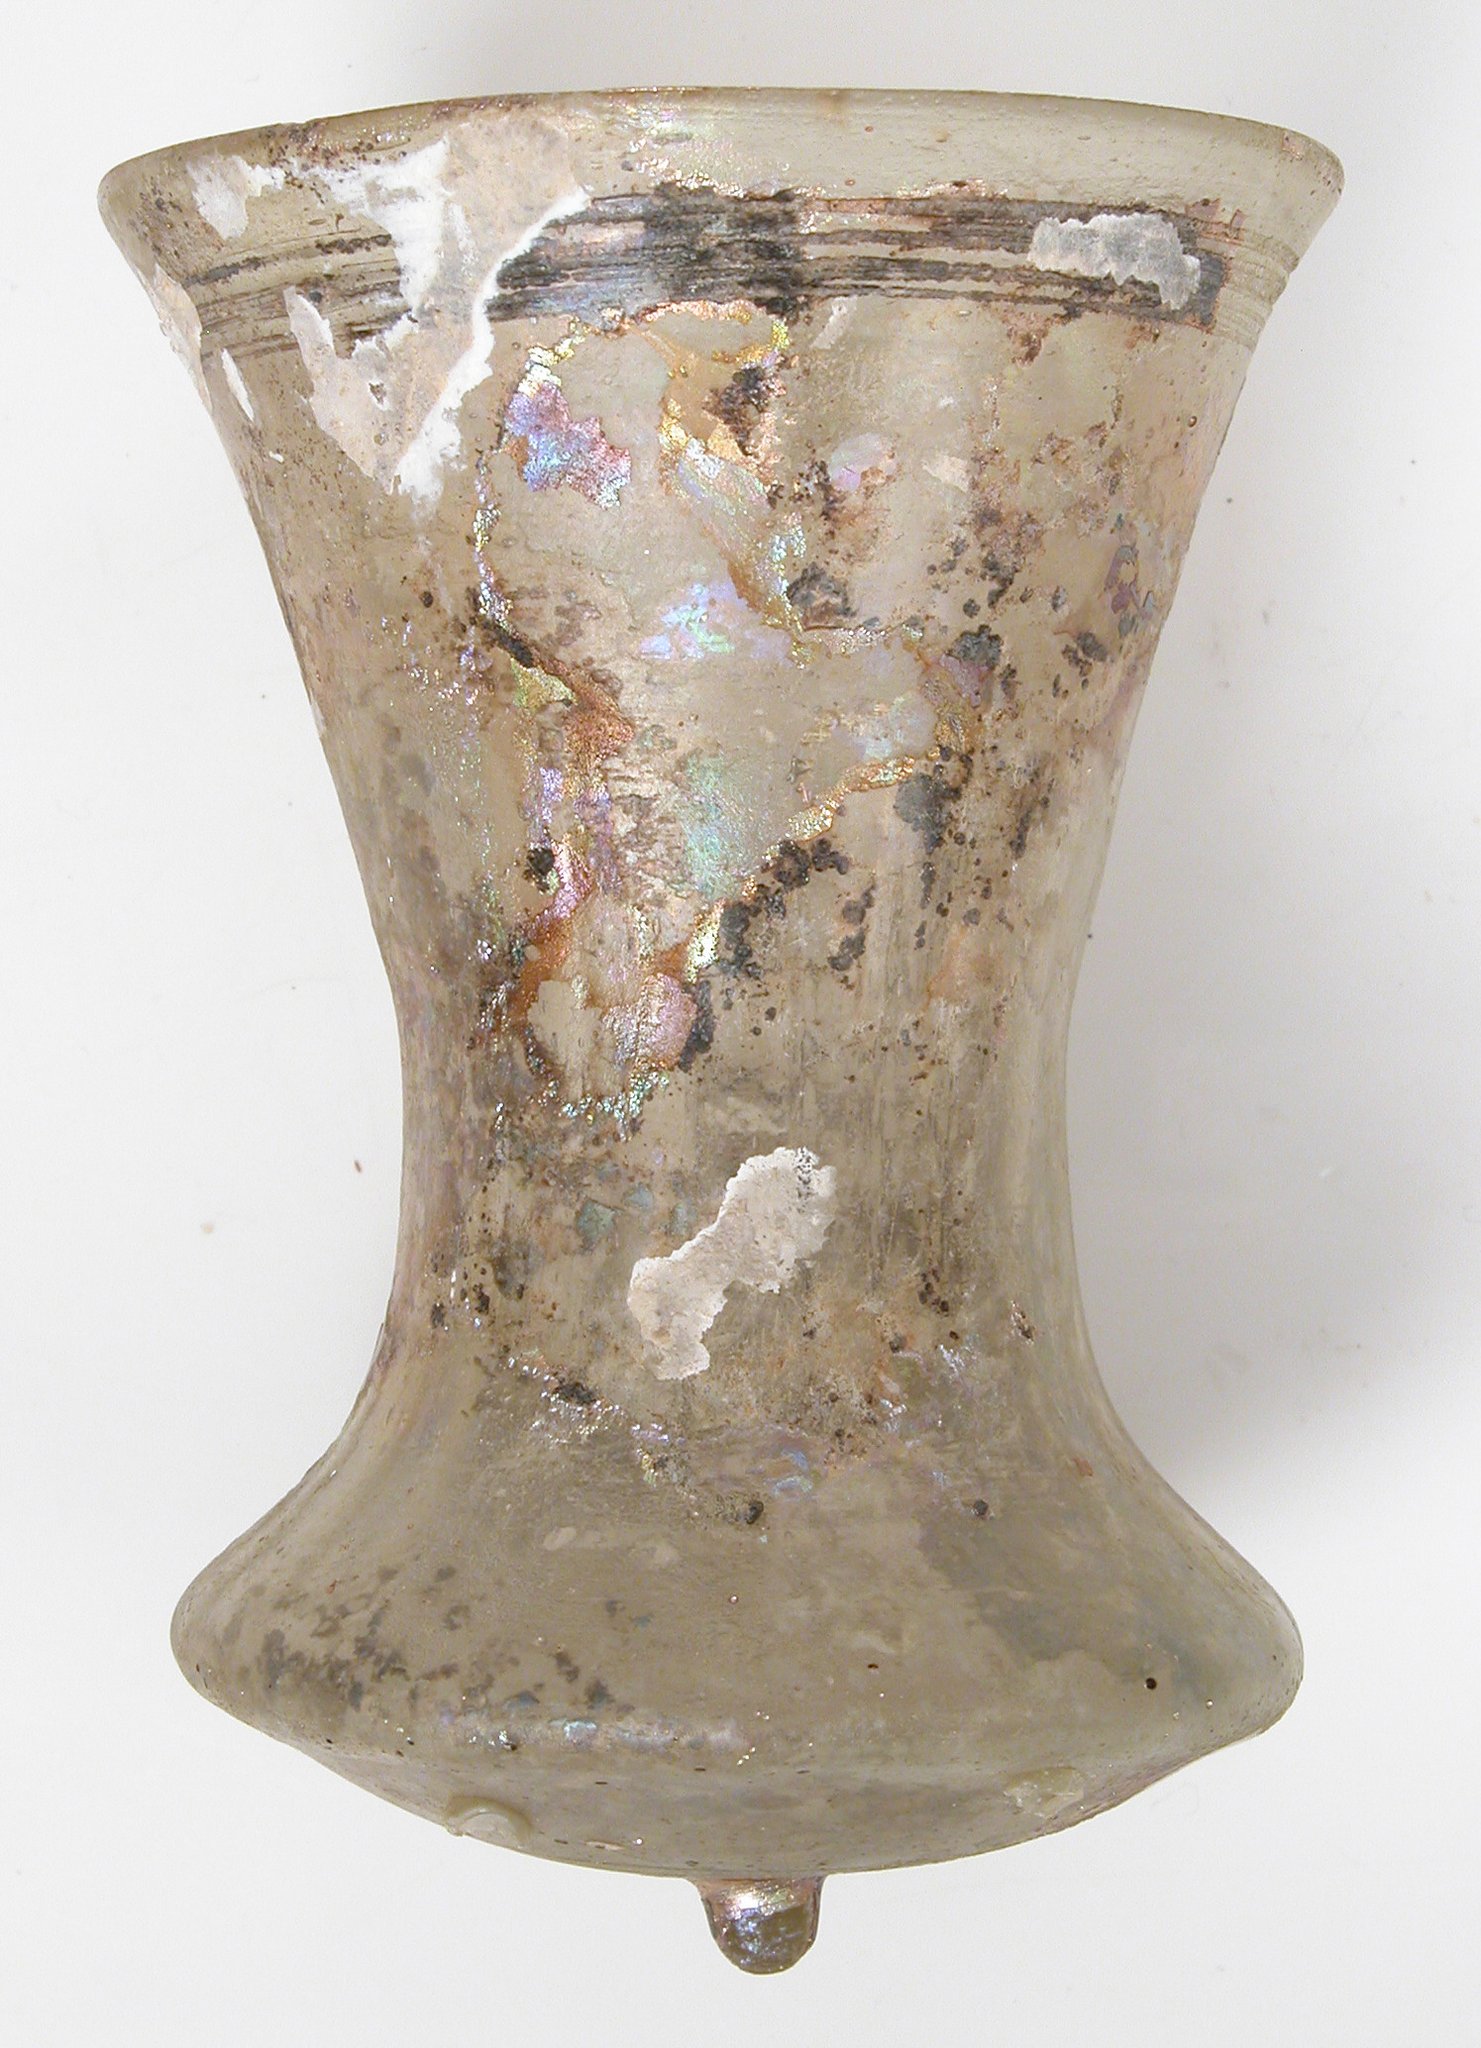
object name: beaker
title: Bell Beaker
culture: roman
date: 401-500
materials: glass